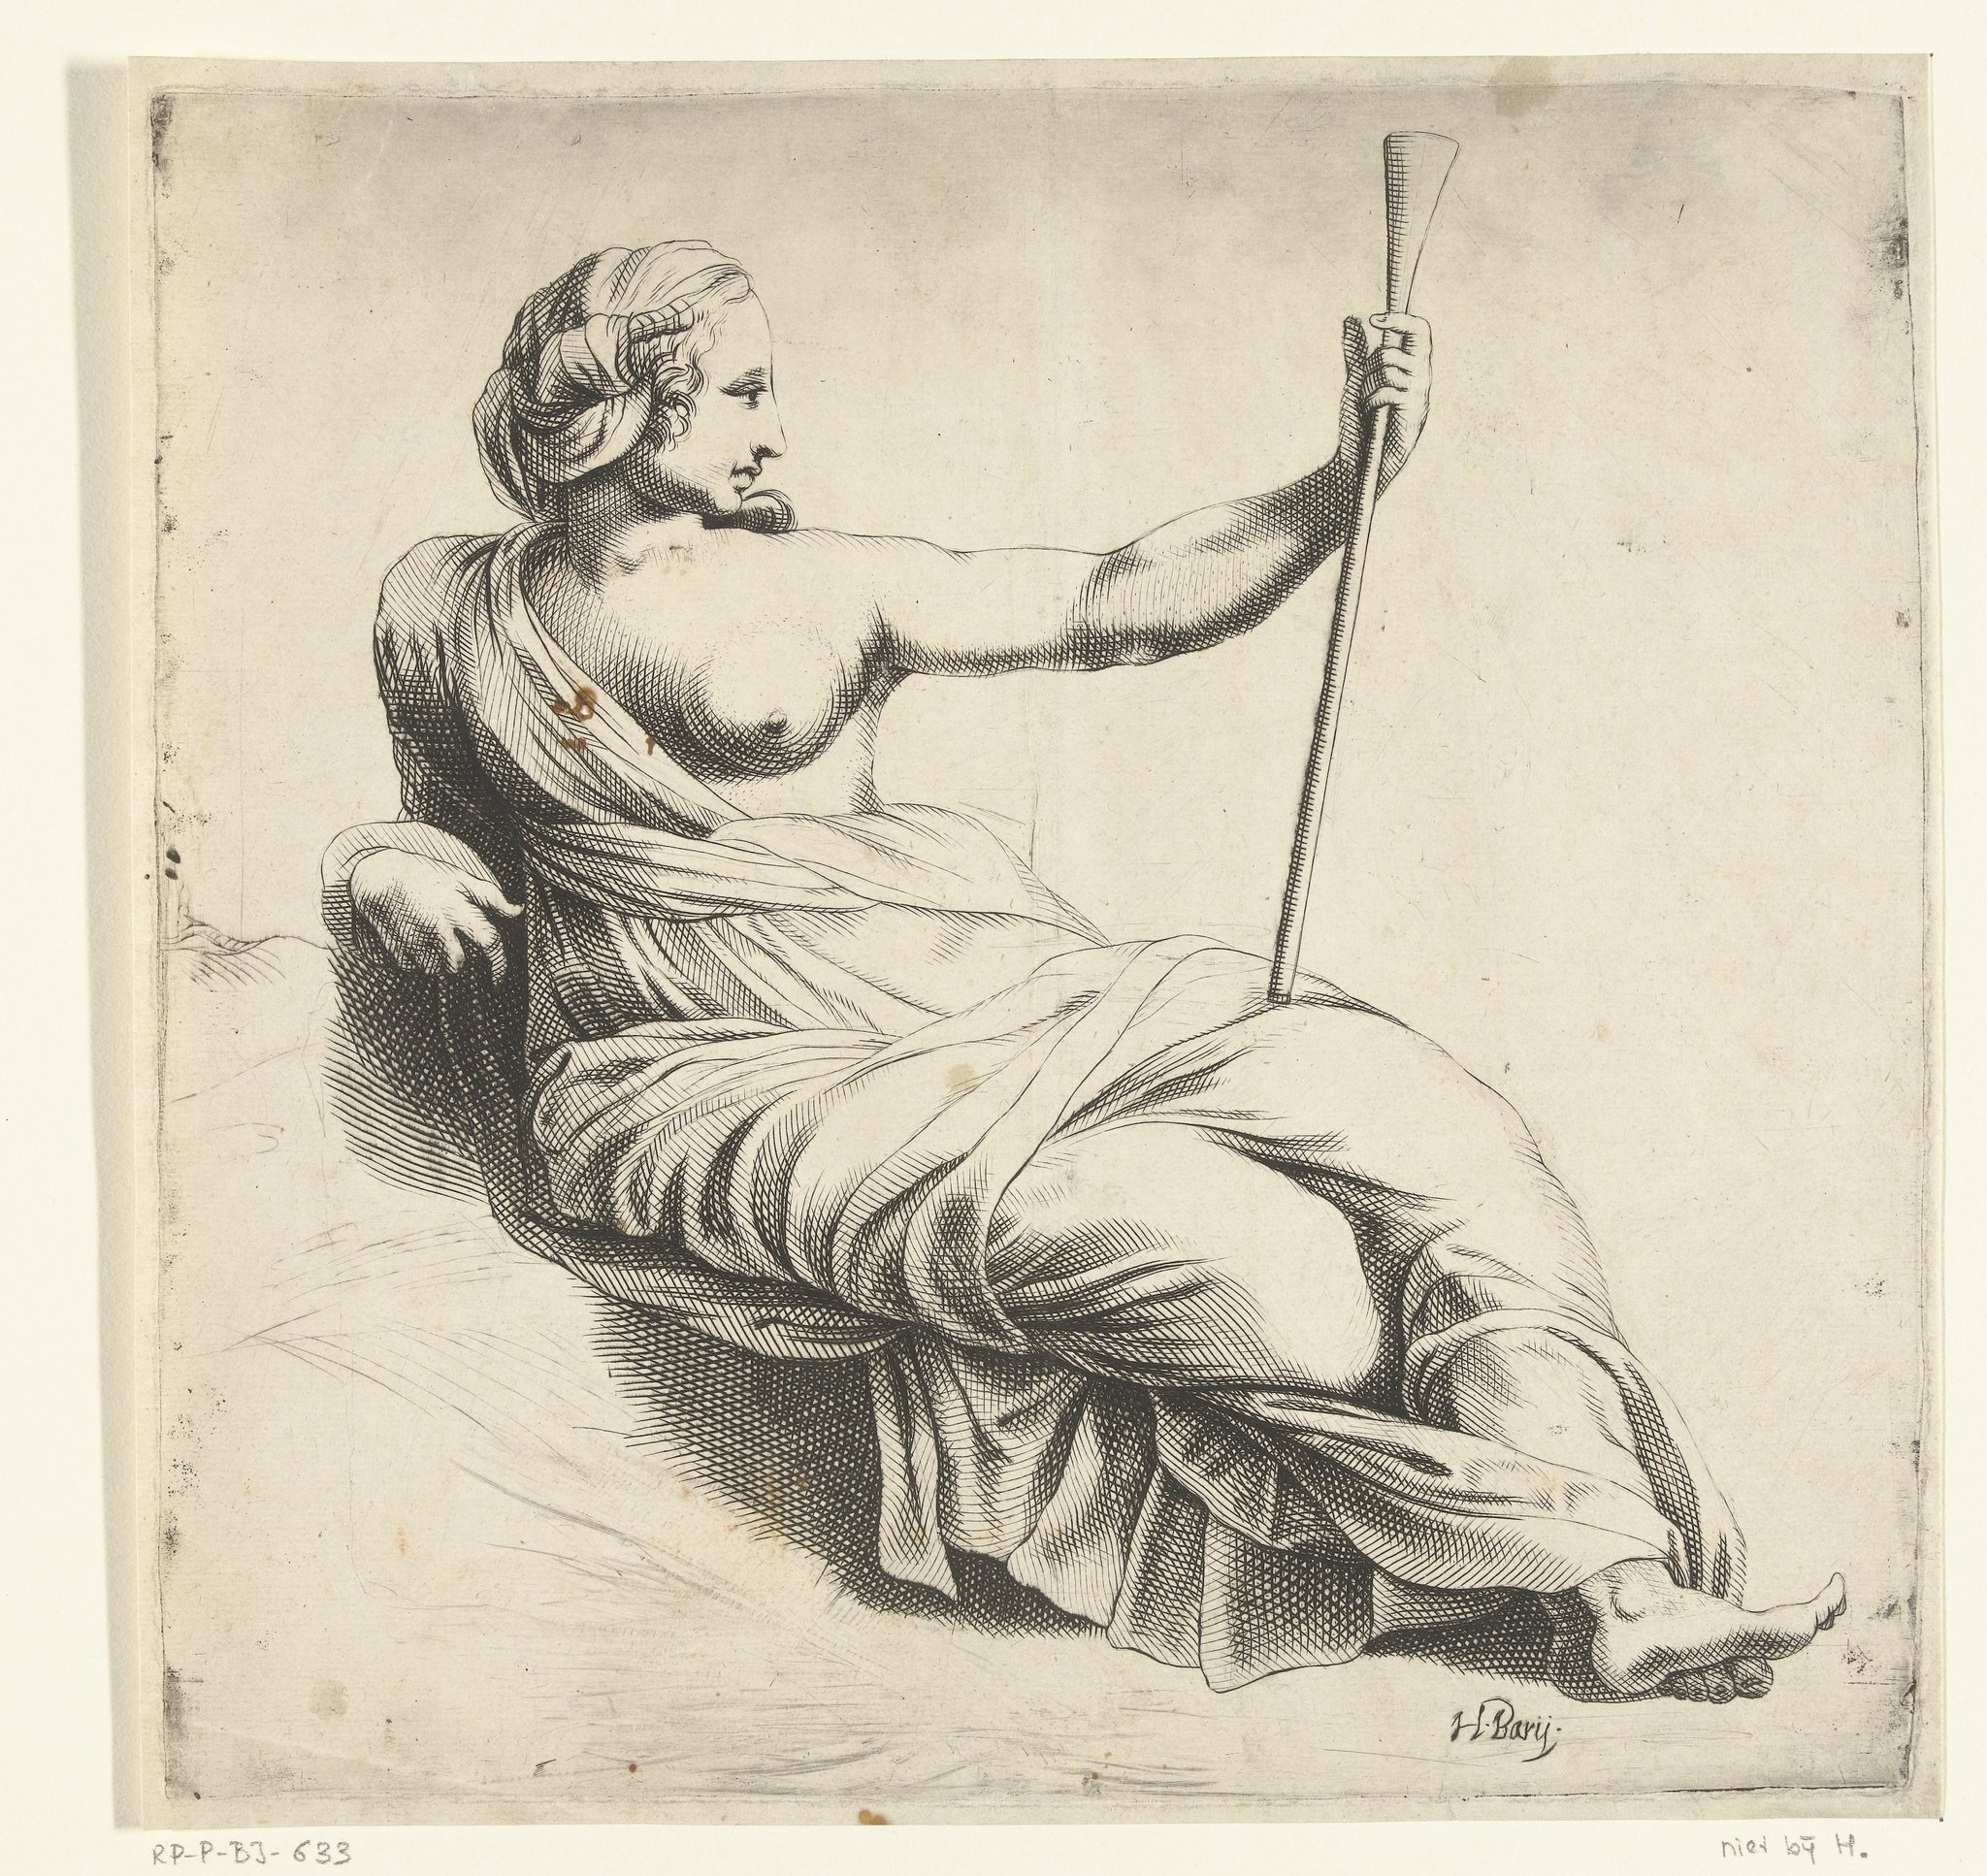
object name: print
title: Een muze der muziek, zittende vrouw met bazuin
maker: hendrik bary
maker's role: draughtsman, print maker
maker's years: 1640-1707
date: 1657-1707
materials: paper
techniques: engraving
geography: netherlands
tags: single muses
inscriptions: collector's mark: Lugt 2228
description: Een muze der muziek, zittende vrouw met bazuin op haar linkerknie.